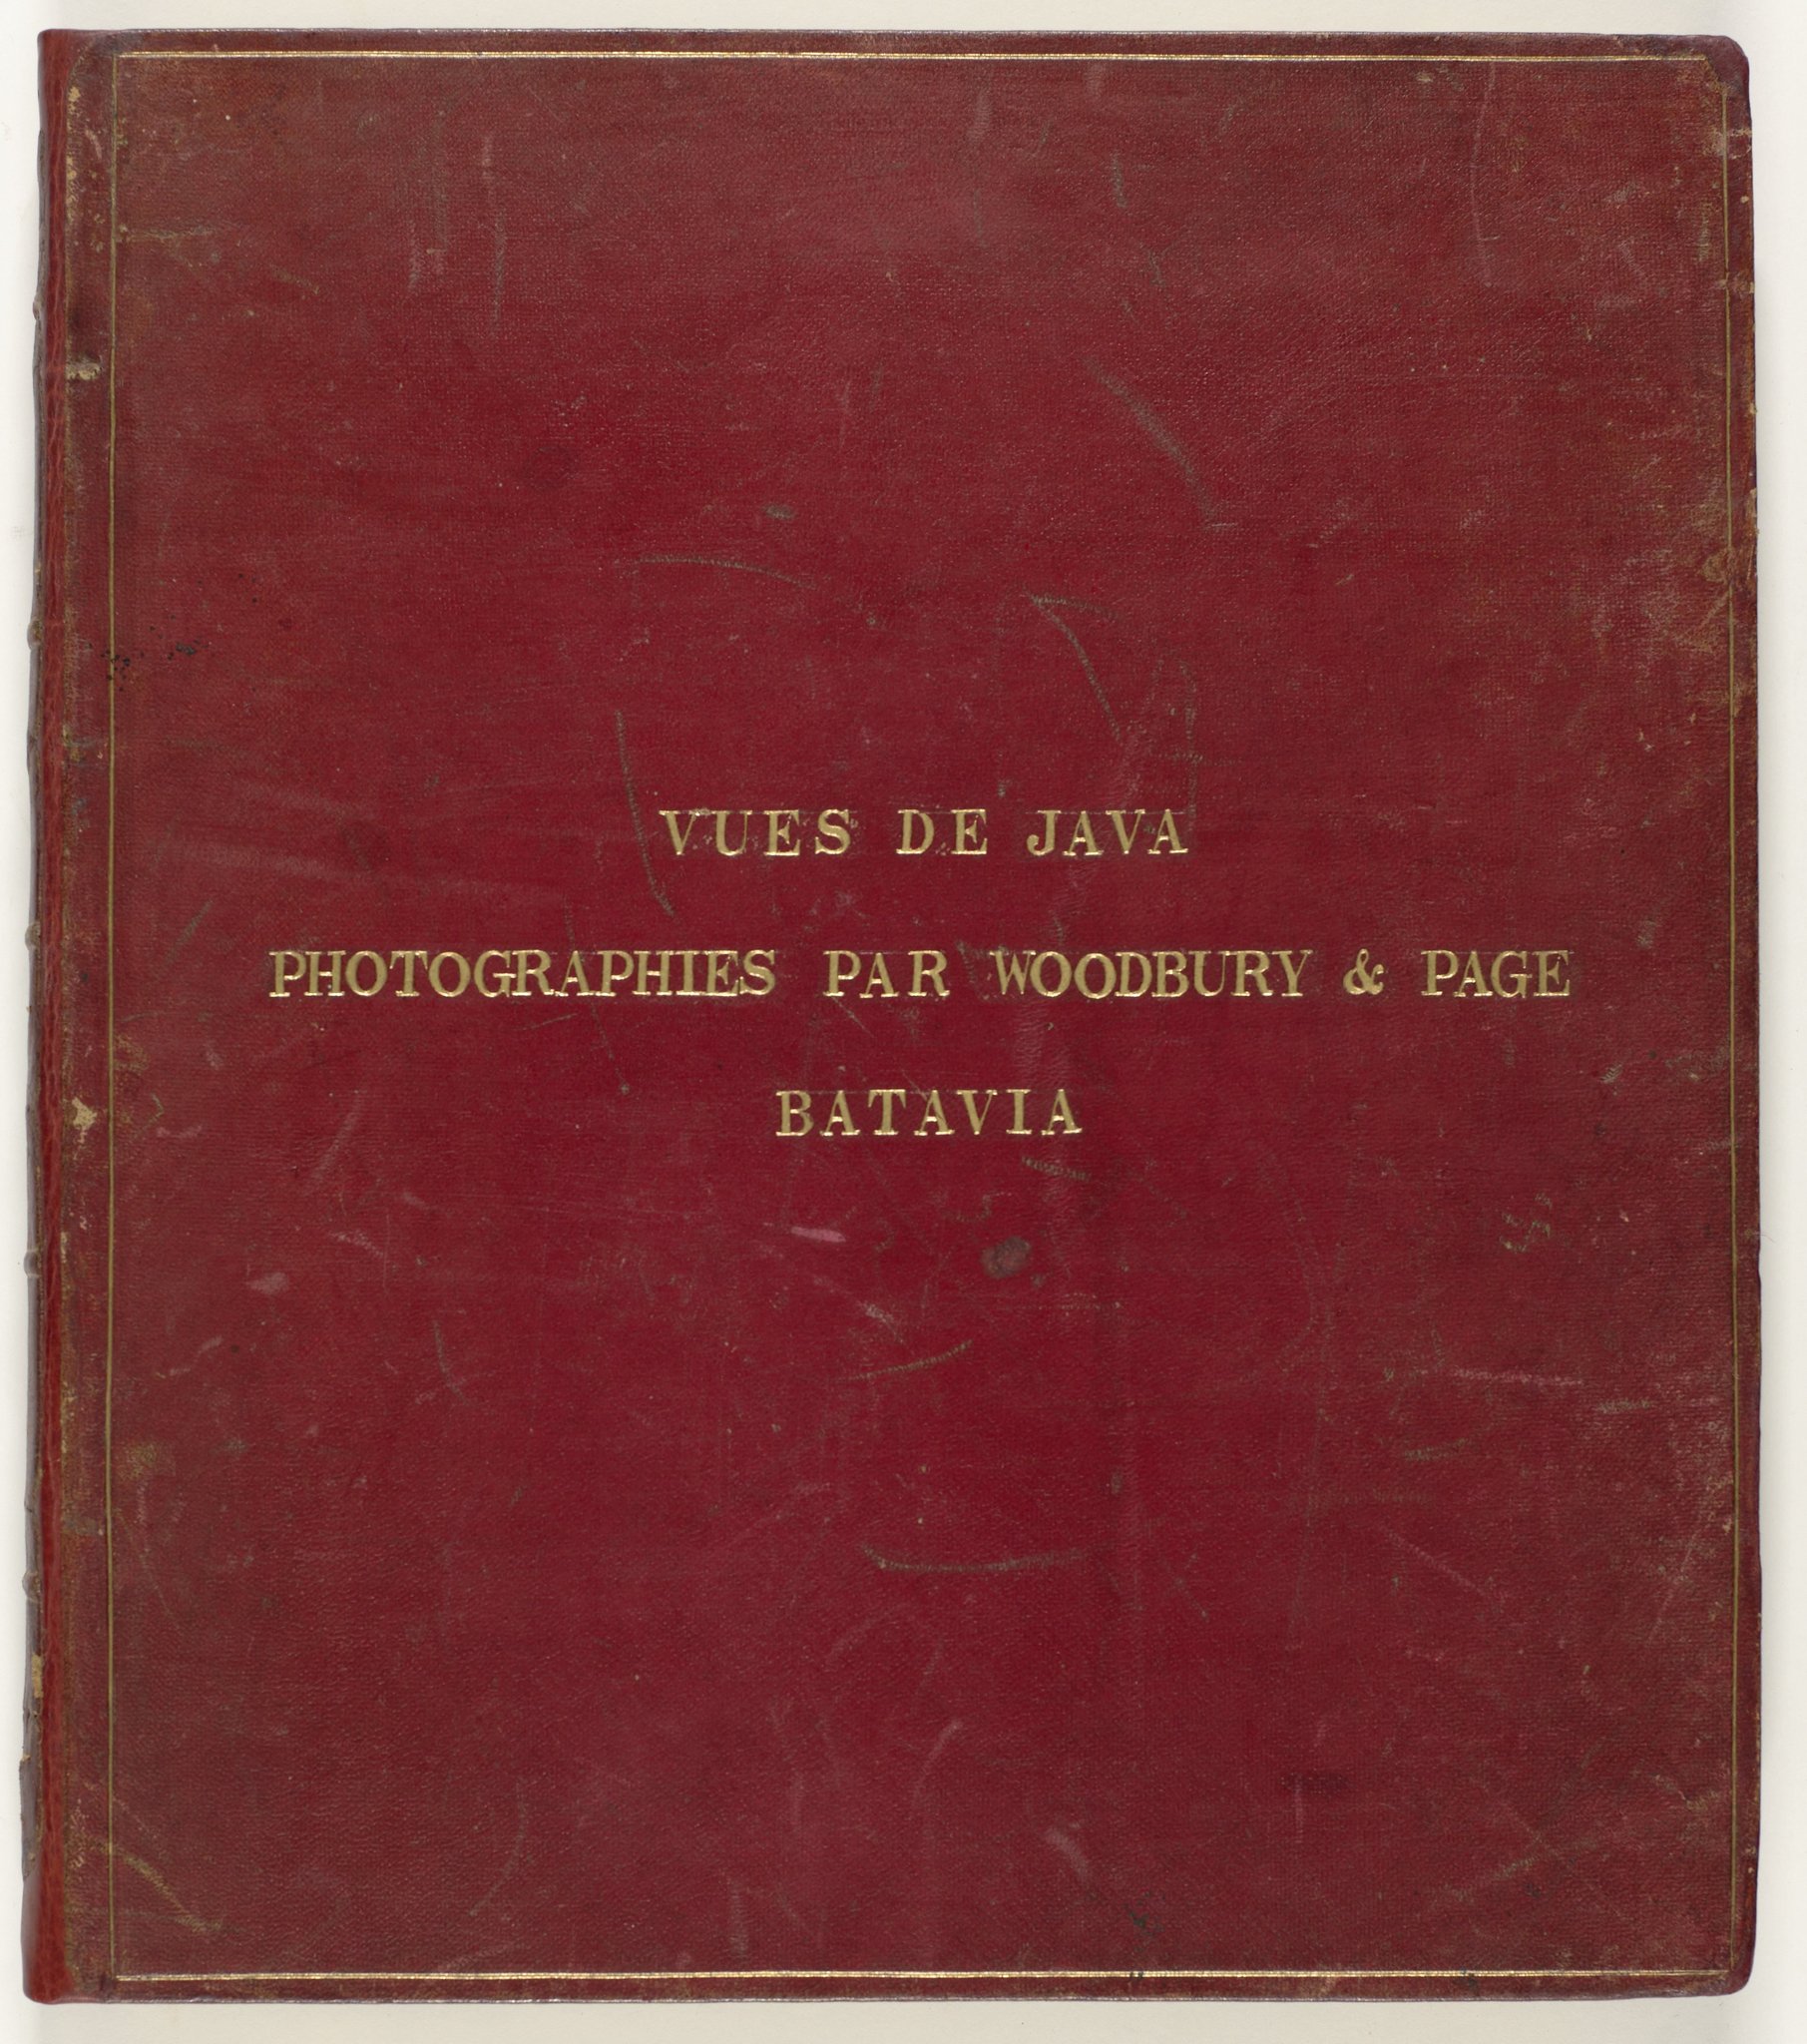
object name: photograph album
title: Vues de Java photographies par Woodbury & Page Batavia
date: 1863-1866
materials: cardboard, photographic support, vegetable tanned sheepskin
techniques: albumen print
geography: batavia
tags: java, batavia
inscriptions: inscription: ‘VUES DE JAVA / PHOTOGRAPHIES PAR WOODBURY & PAGE / BATAVIA’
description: Album met vergulde sneden in rode band van schapenleer met letters in goud, met foto's van Java uit het bezit van apotheker Specht-Grijp, die in 1865 vanuit Batavia naar Nederland terugkeerde. Het album bevat 25 bladen van karton met op beide zijden één foto ingeplakt, in totaal 49 foto's van gezichten in Batavia. Bij de foto's in het album staan bijschriften in drie verschillende handschriften. De eerste foto in het album is een portret van drie heren, de mogelijke aanbieders van het boek aan Specht-Grijp.